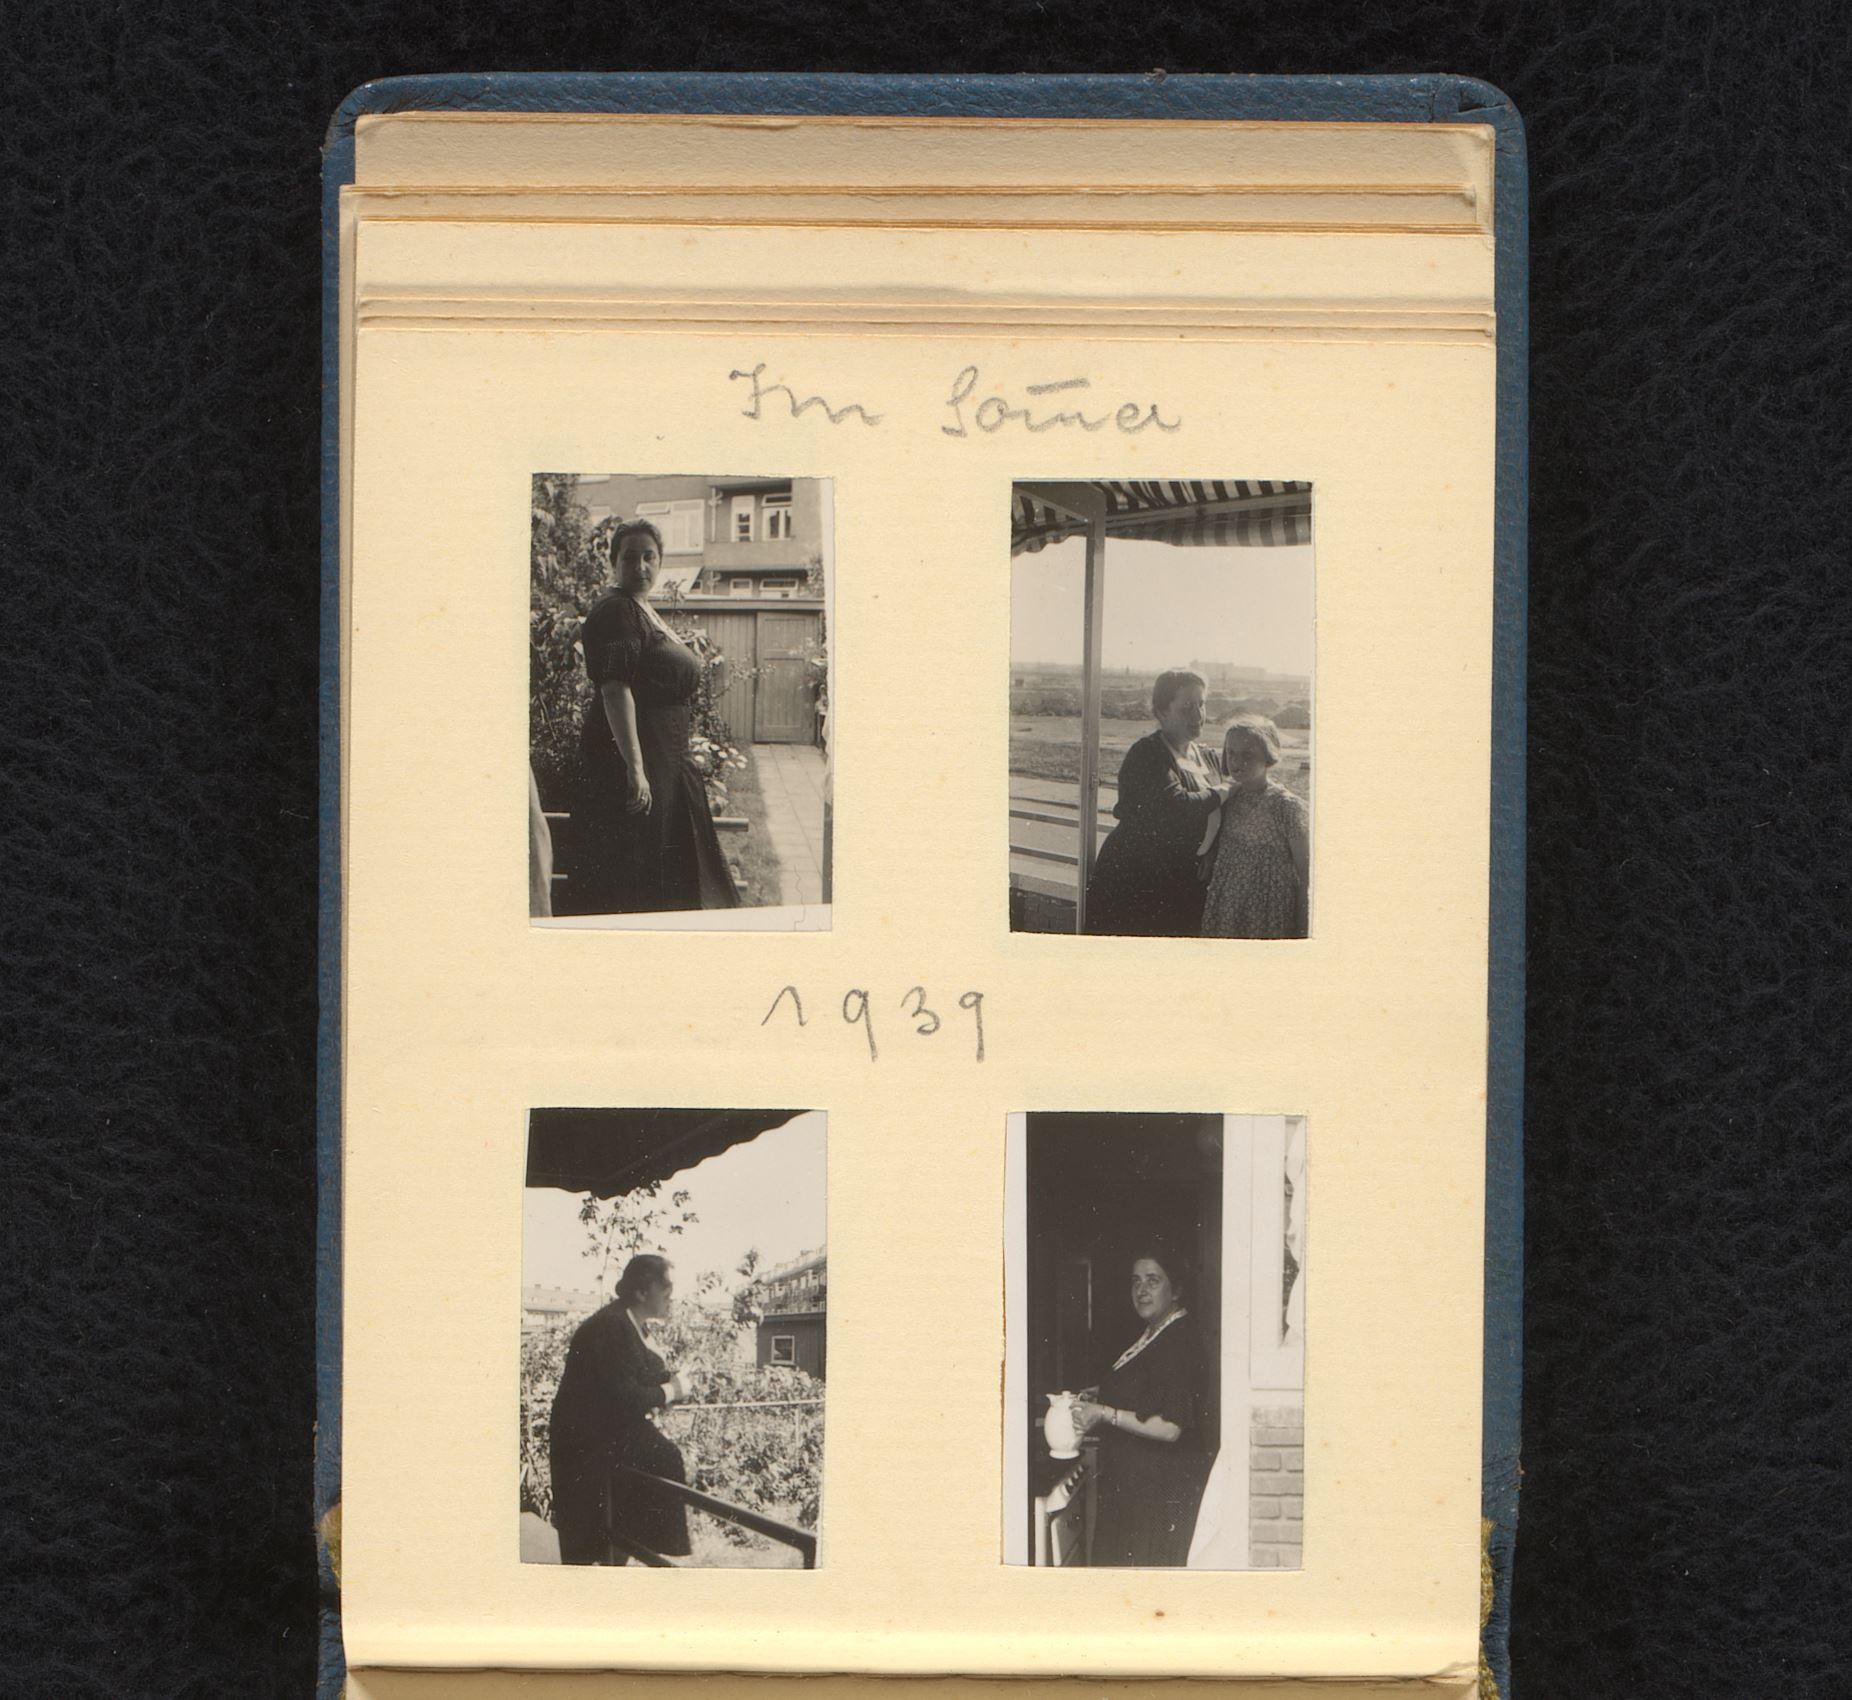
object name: album leaf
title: Isabel Wachenheimer met haar moeder Else Wachenheimer-Moos in de woning van de familie Wachenheimer (Van Aerssenlaan 22), zomer 1939, Rotterdam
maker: else wachenheimer-moos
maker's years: 1895-1944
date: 1939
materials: paper, photographic support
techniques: gelatin silver print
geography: rotterdam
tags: else wachenheimer-moos, isabel wachenheimer-elon, historical persons - bb - woman, family life at home, rotterdam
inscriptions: inscription: ‘Im Sommer 1939’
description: Albumblad bevat vier foto's. Alle foto's van Isabel Wachenheimer (als klein meisje) en Else Wachenheimer-Moos (als volwassen vrouw). Uit klein formaat fotoalbum, blauw lederen omslag met drukknopsluiting. Met foto's in klein formaat.